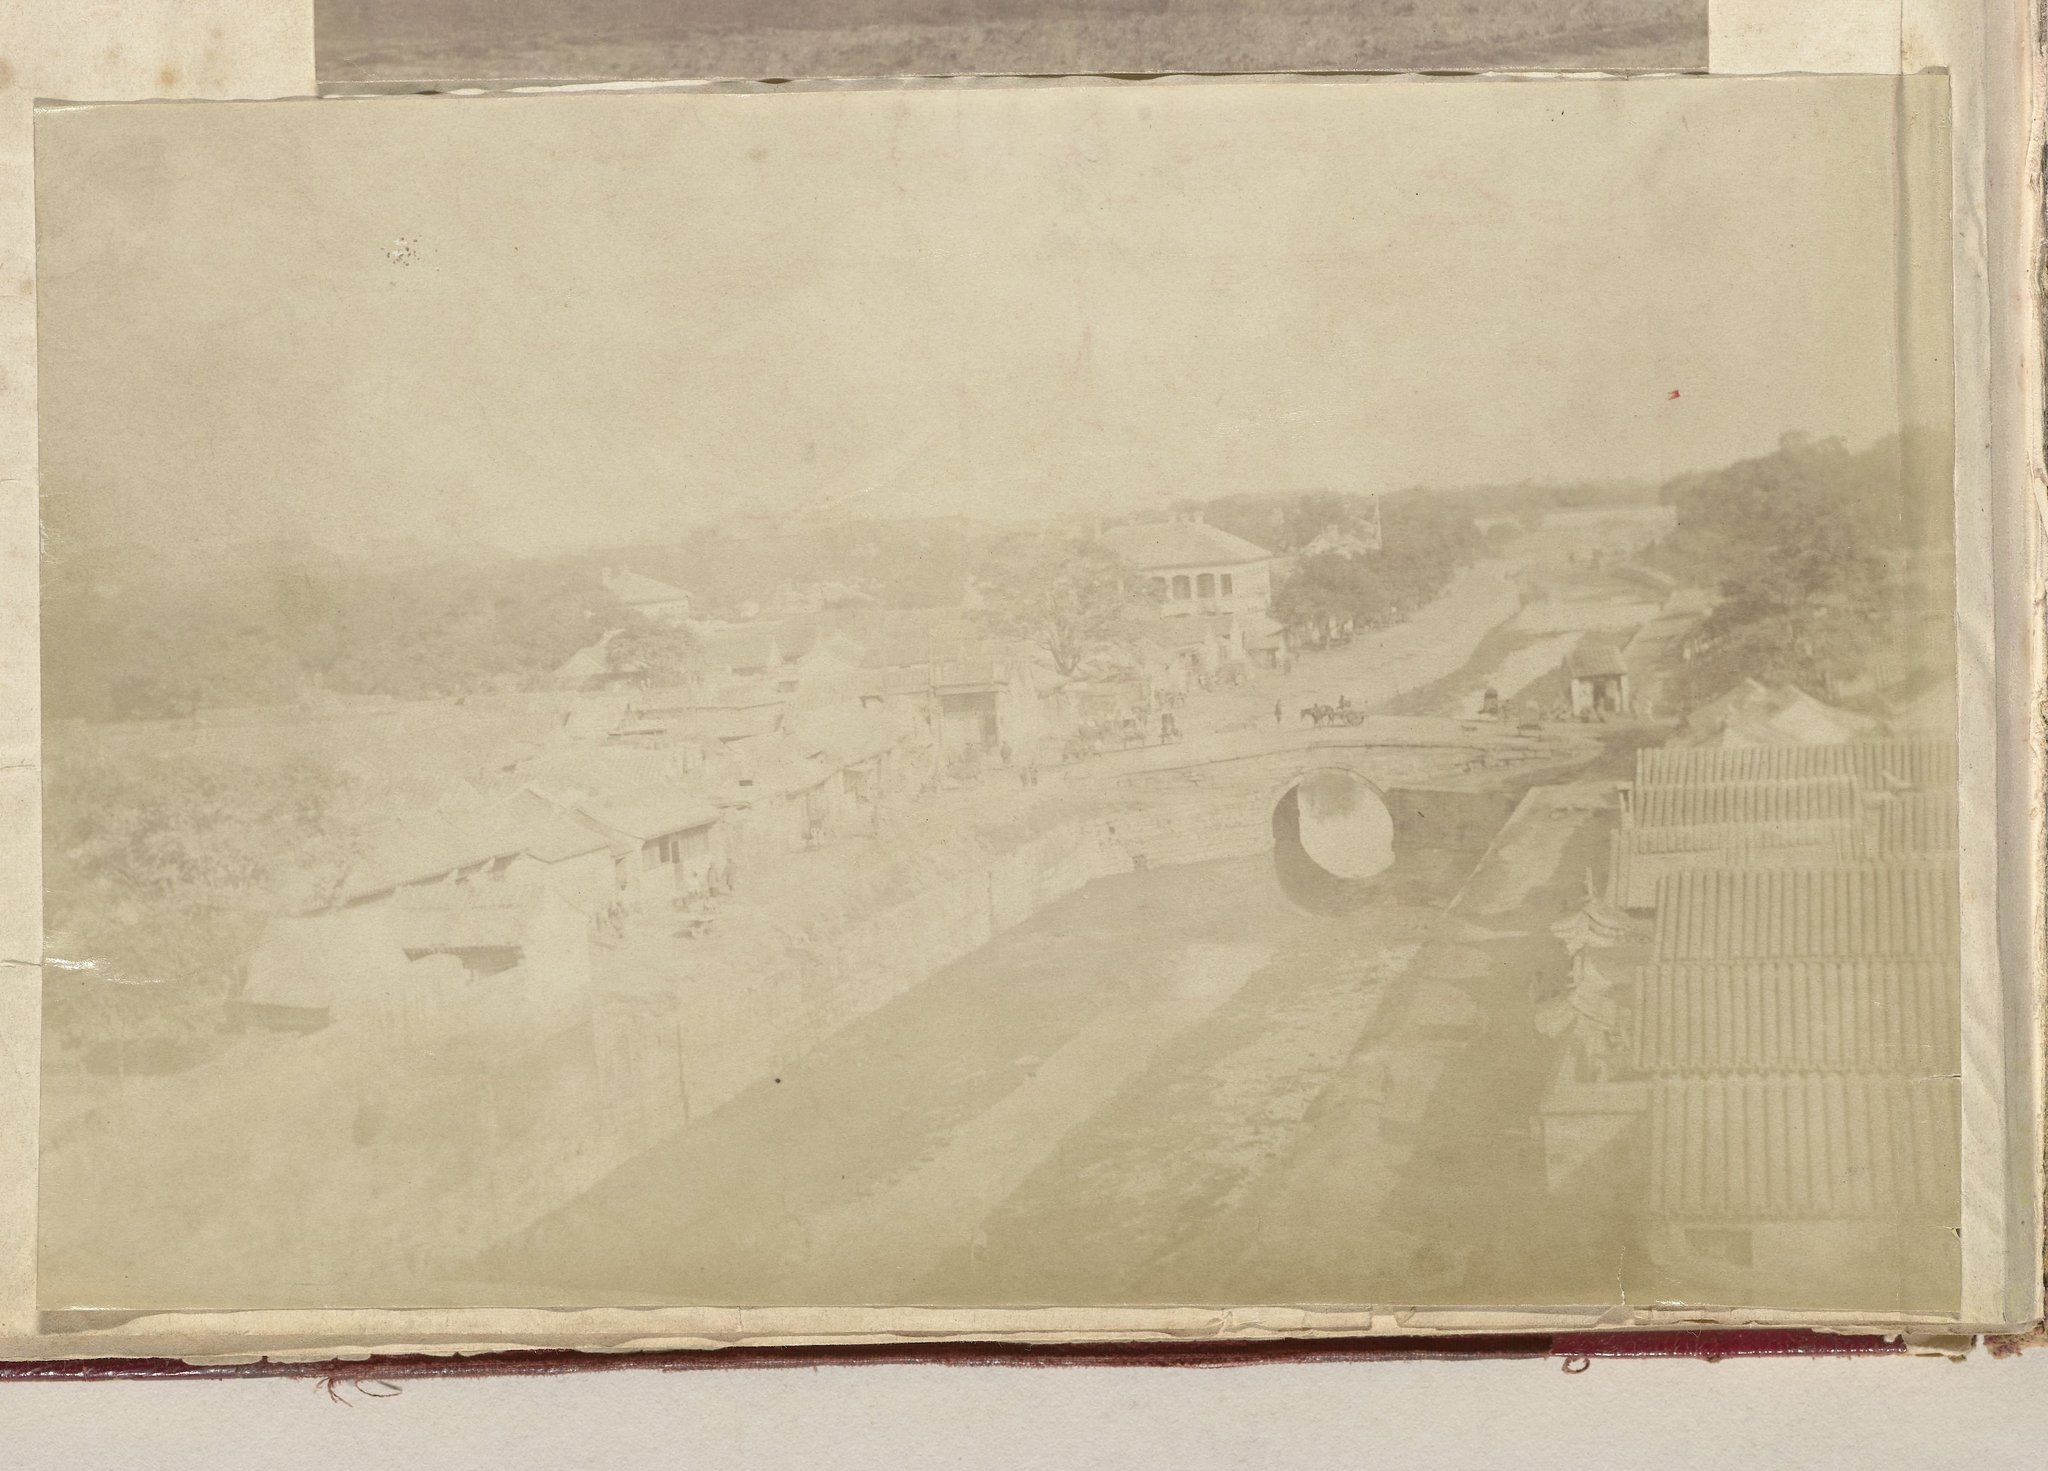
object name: album leaf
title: Huizen aan een gracht, mogelijk in Beijing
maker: Anonymous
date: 1879-1890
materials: paper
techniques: albumen print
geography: china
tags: urban housing, bridge in city across river, canal, etc.